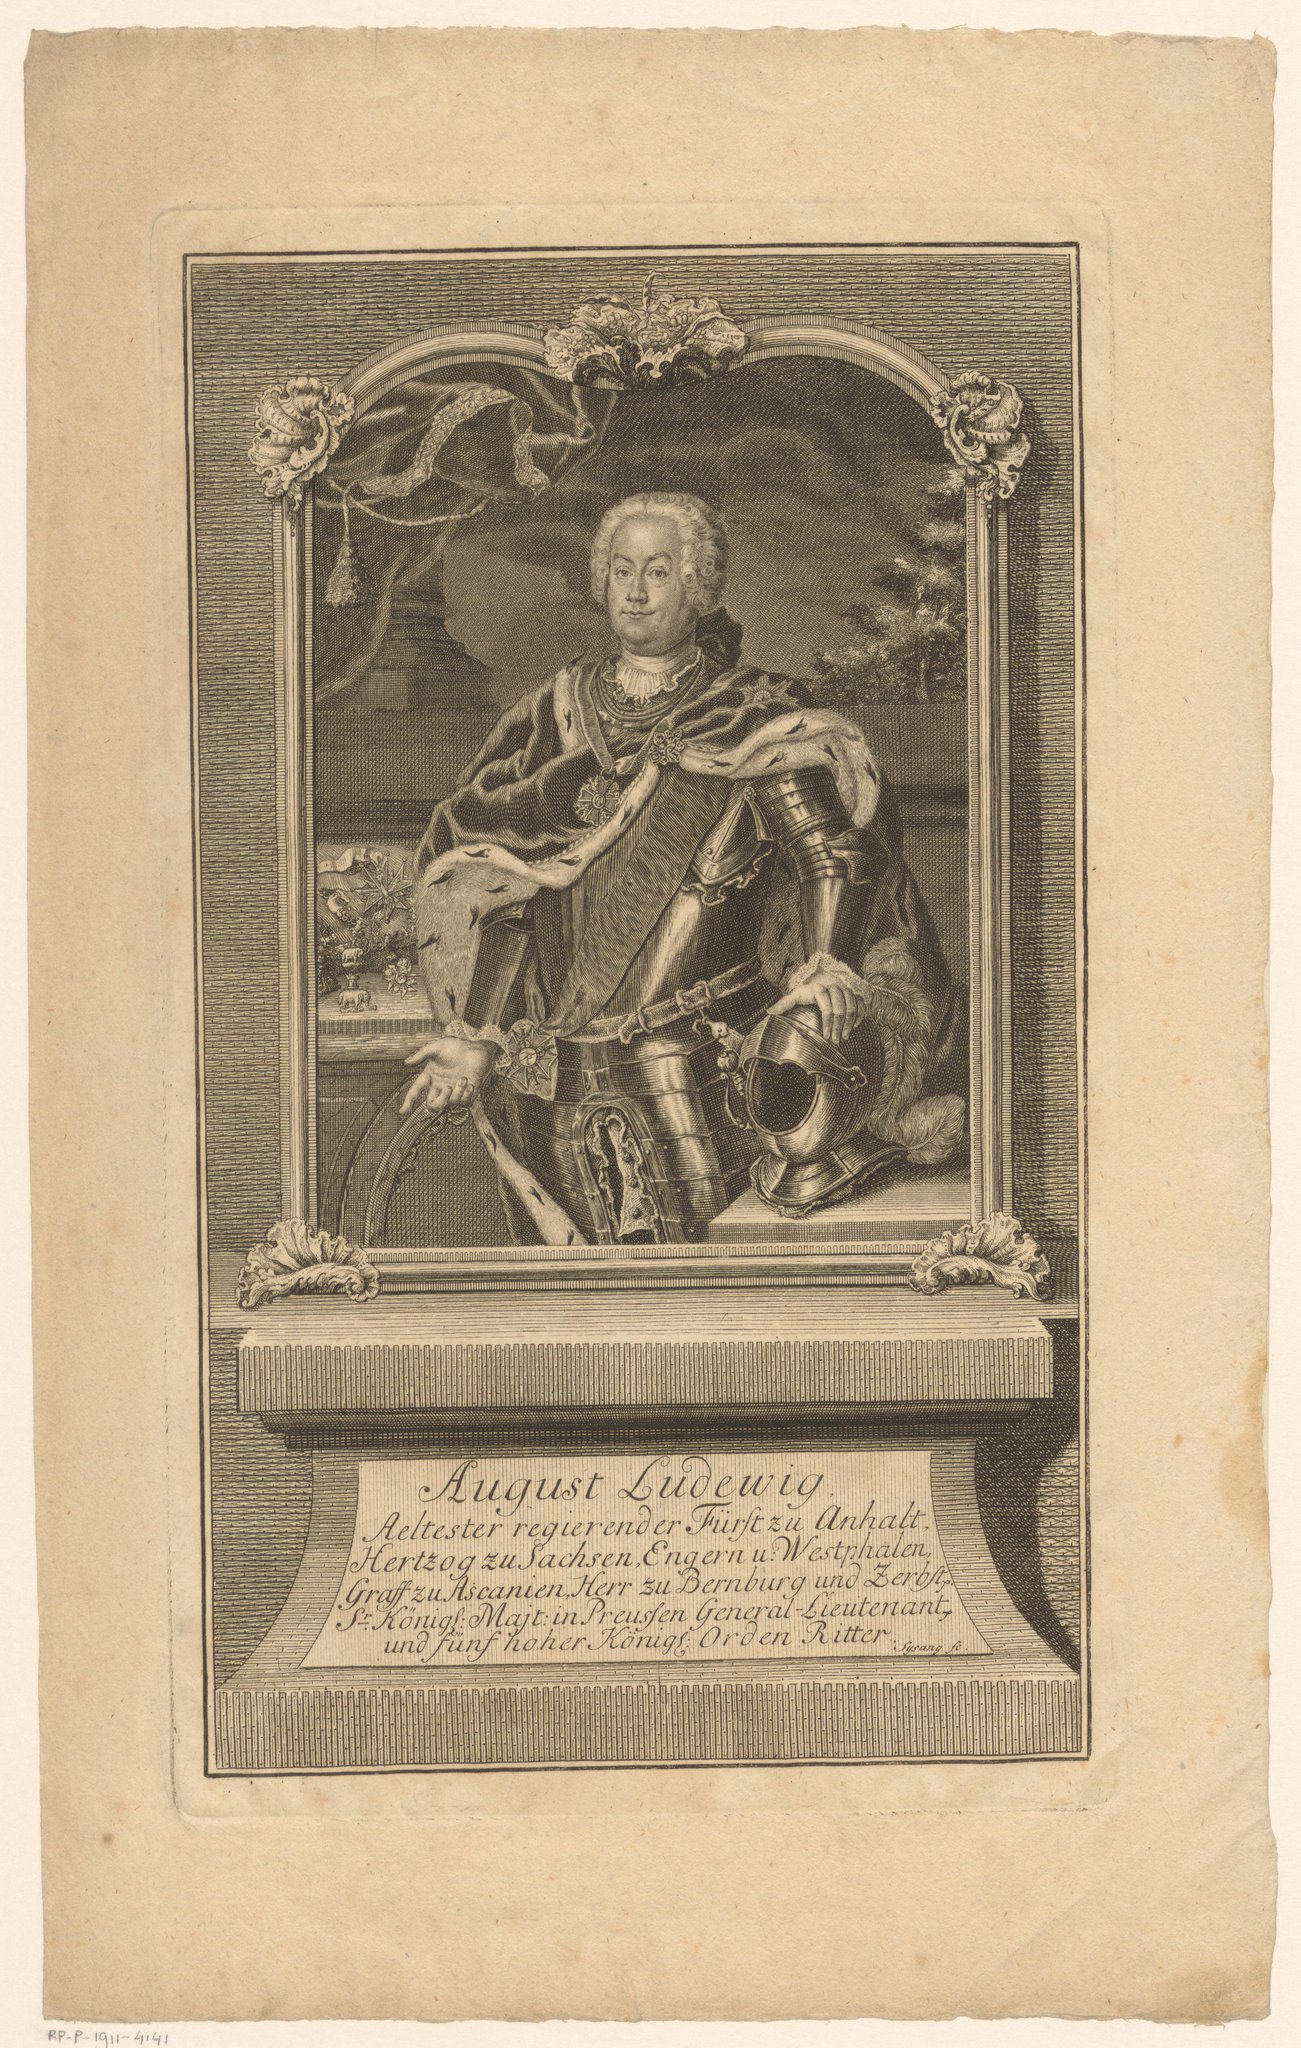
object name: print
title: Portret van August Ludwig von Anhalt-Köthen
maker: johann christoph sysang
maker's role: print maker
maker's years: 1703-1757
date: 1730-1757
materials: paper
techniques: engraving, etching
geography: germany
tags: helmet, armour, historical persons, knighthood order (elephant)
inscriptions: collector's mark: Lugt 2228